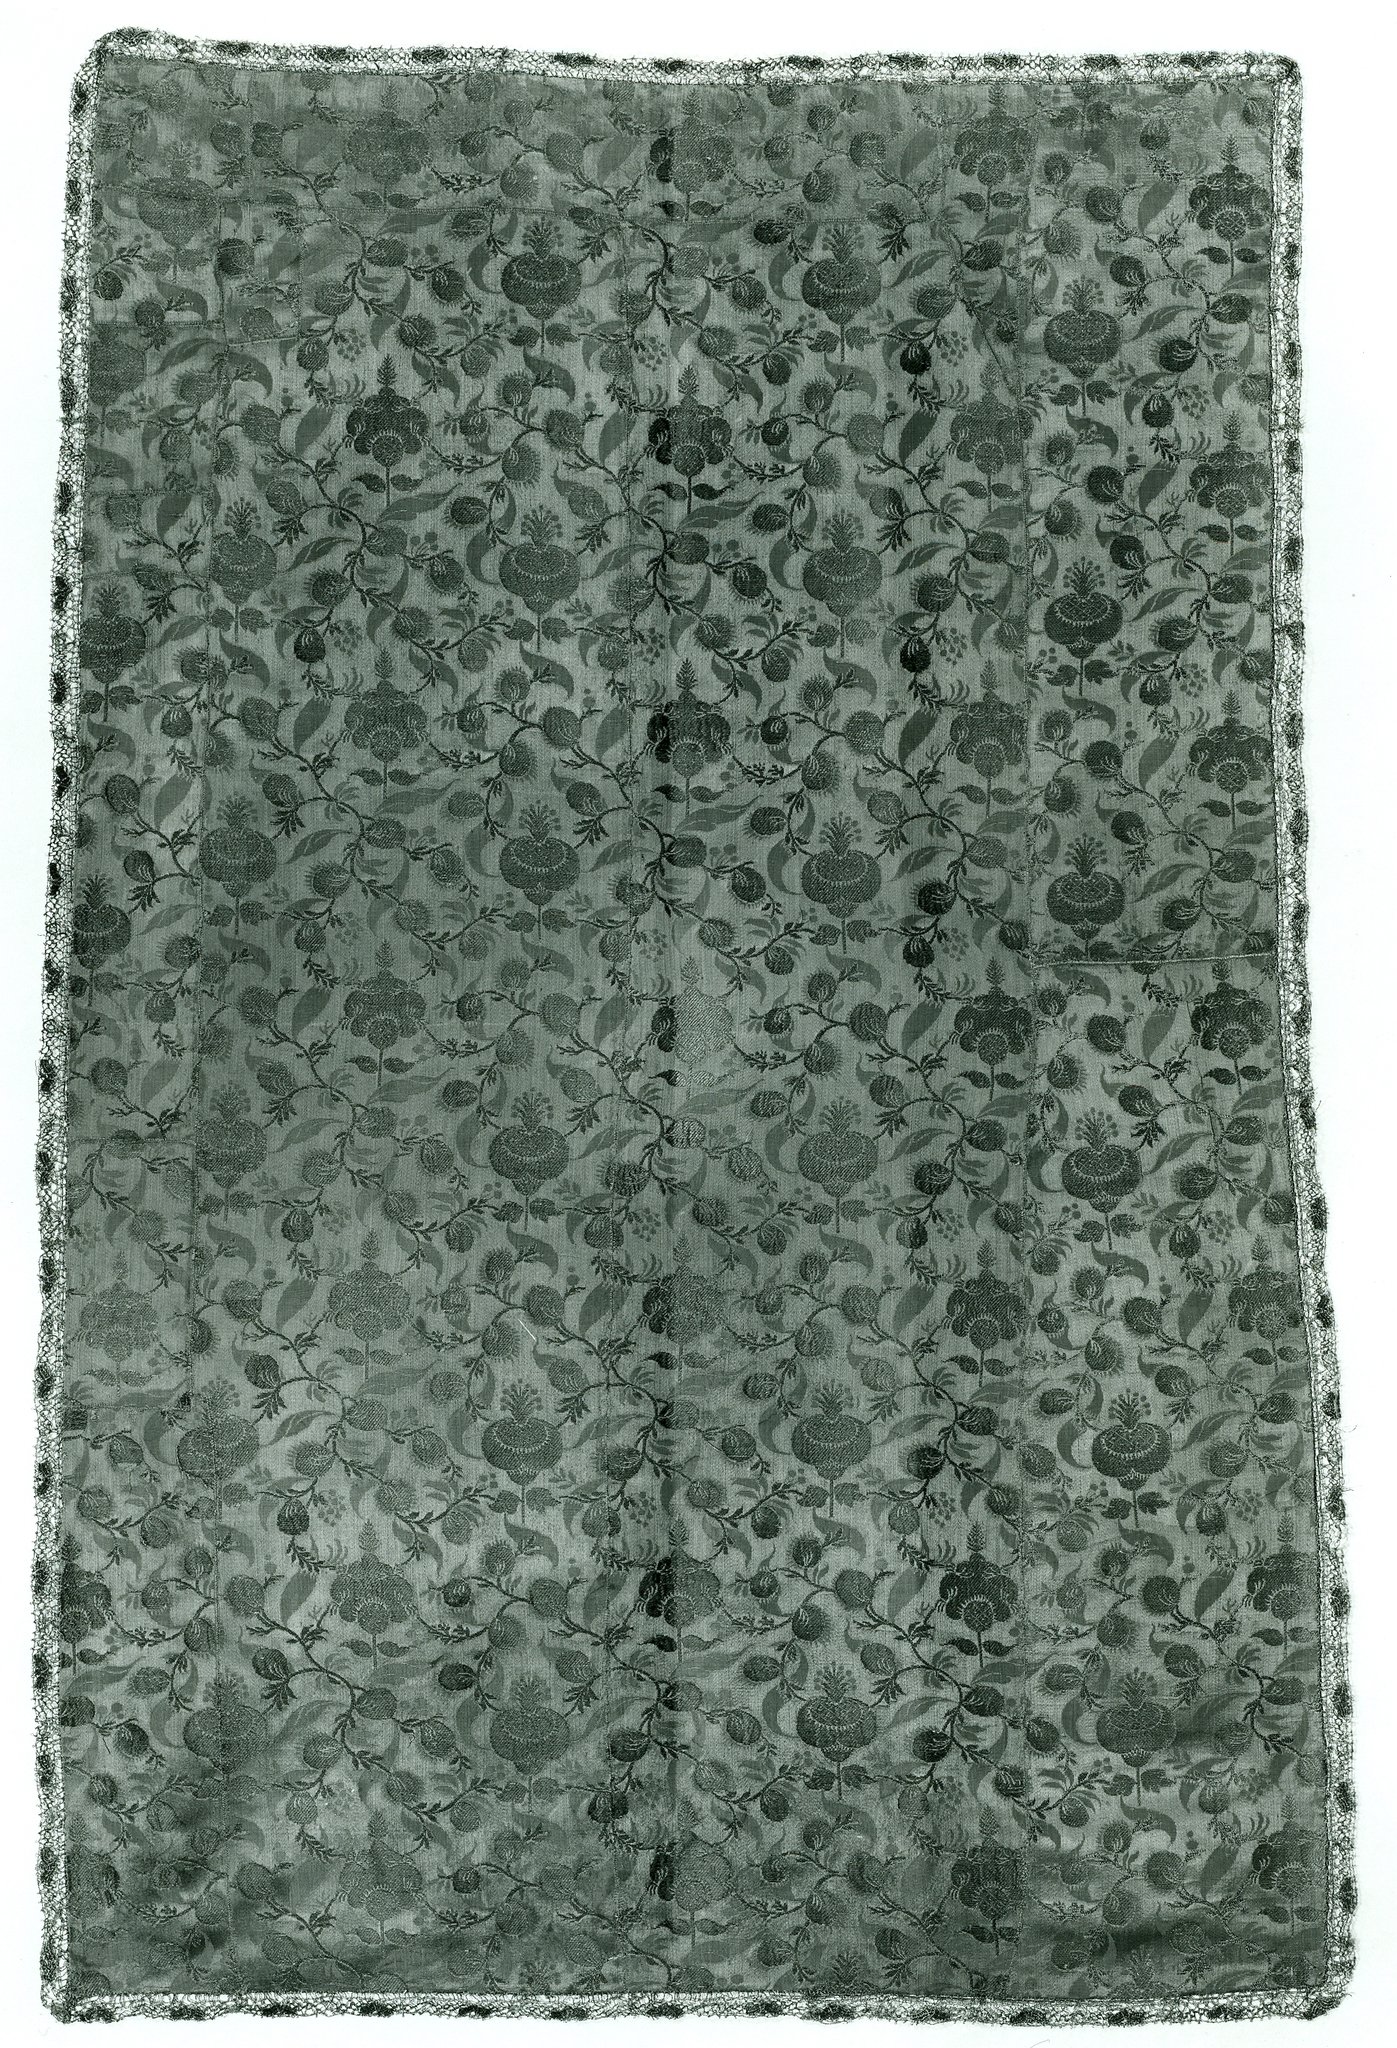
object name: textile panel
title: Panel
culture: french or italian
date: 1701-1800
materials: metal, silk